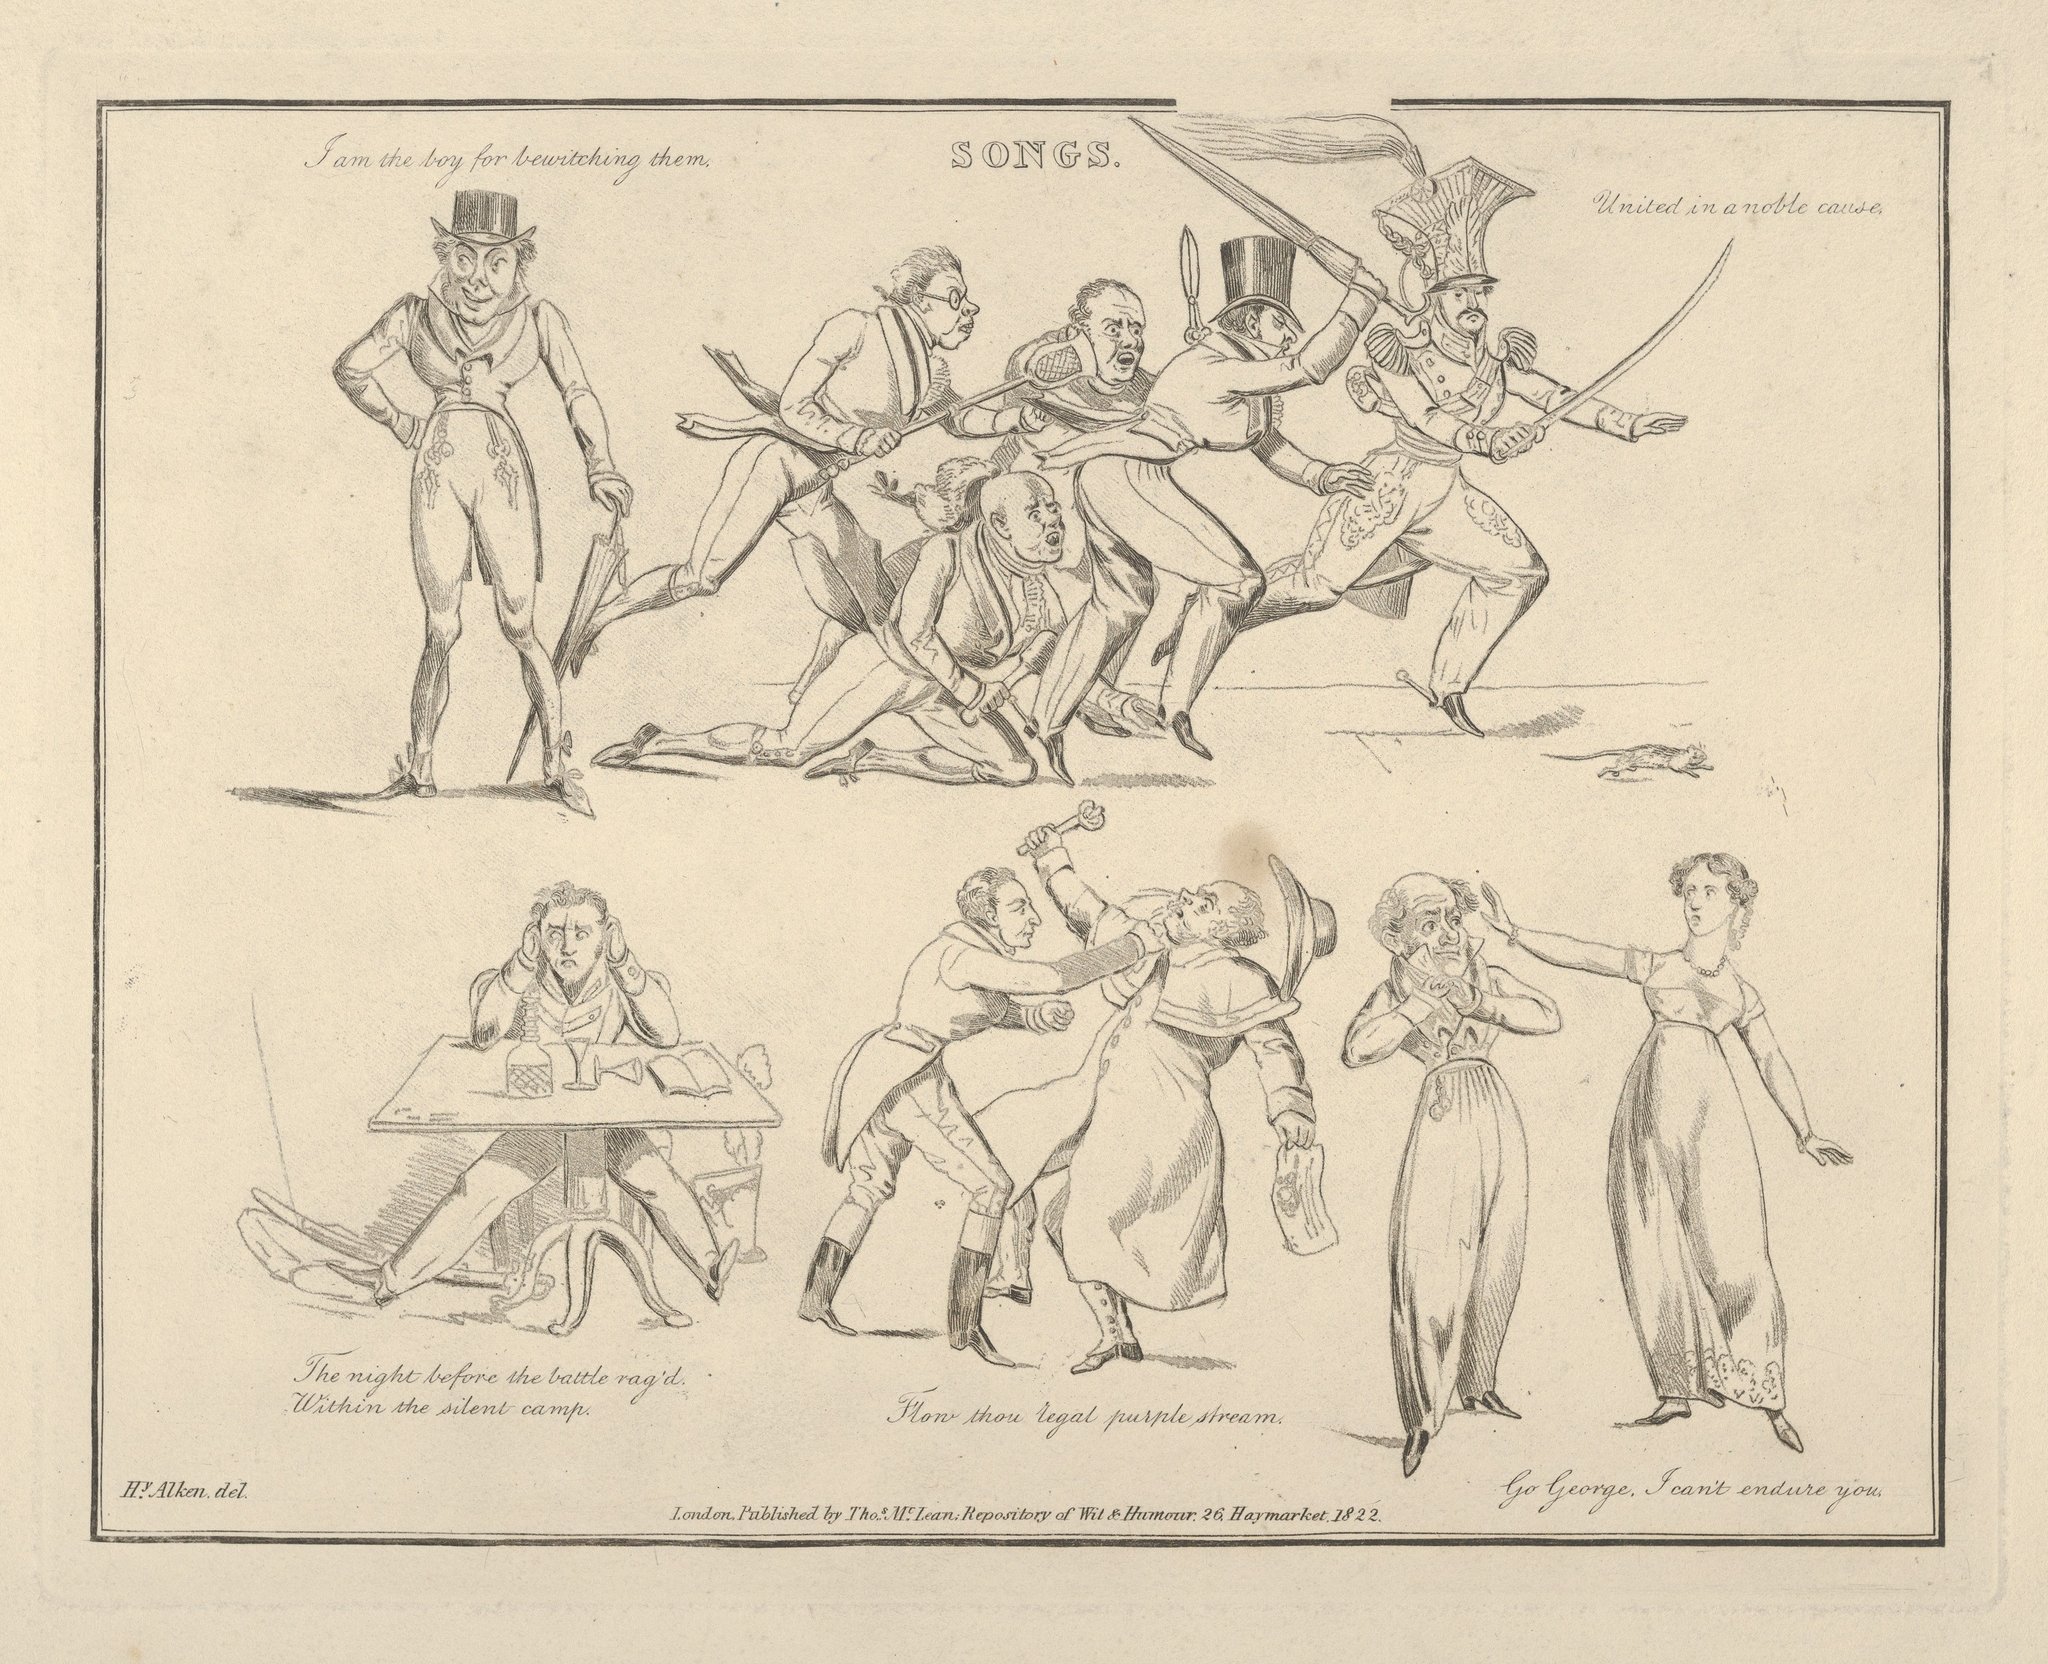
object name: print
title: Songs: "I am the boy for bewitching them..."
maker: henry alken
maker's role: artist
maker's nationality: british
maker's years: 1785-1851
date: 1822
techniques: etching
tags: swords,men,women